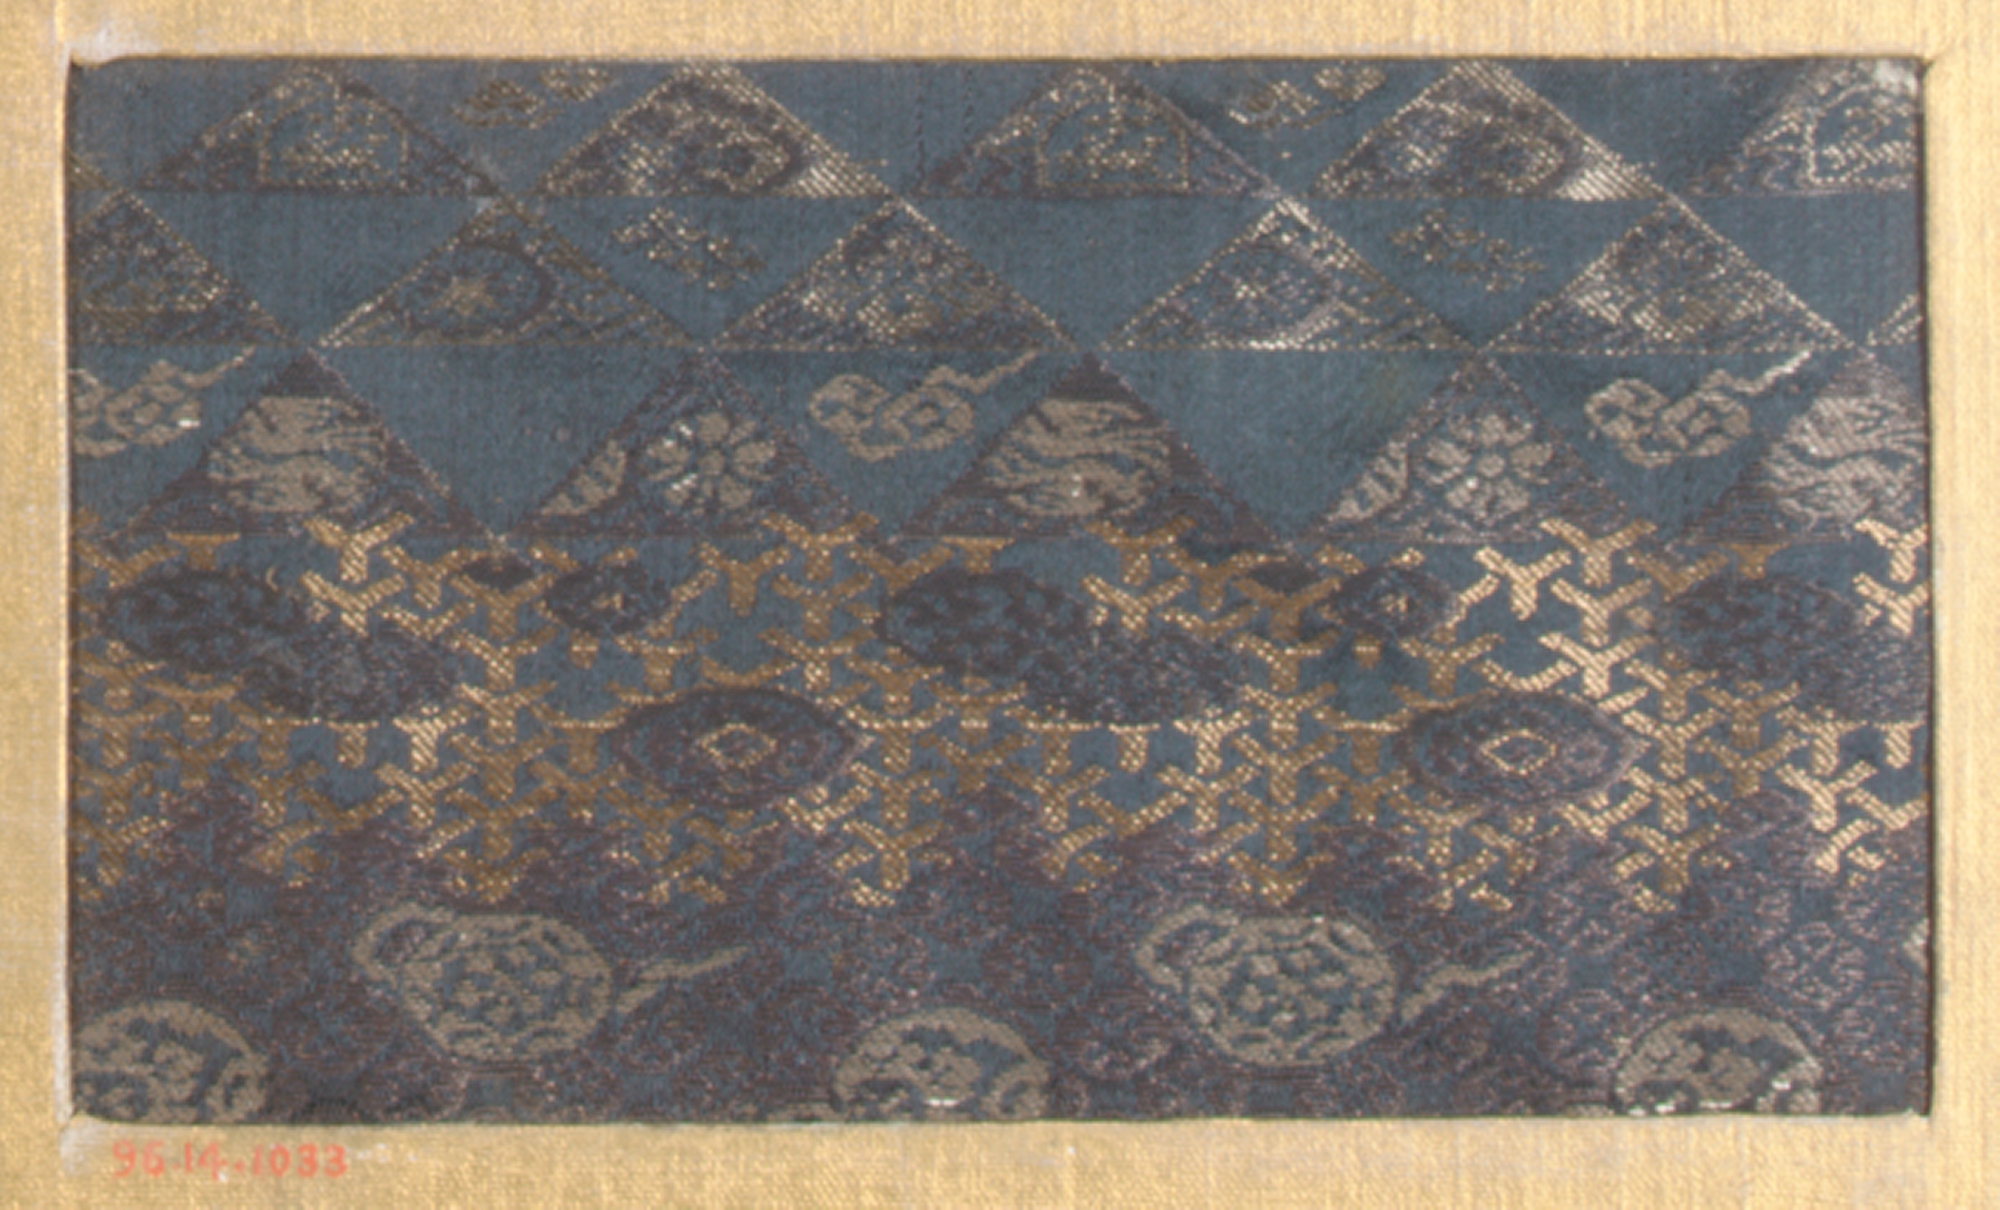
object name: piece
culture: japanese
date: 1701-1900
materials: silk